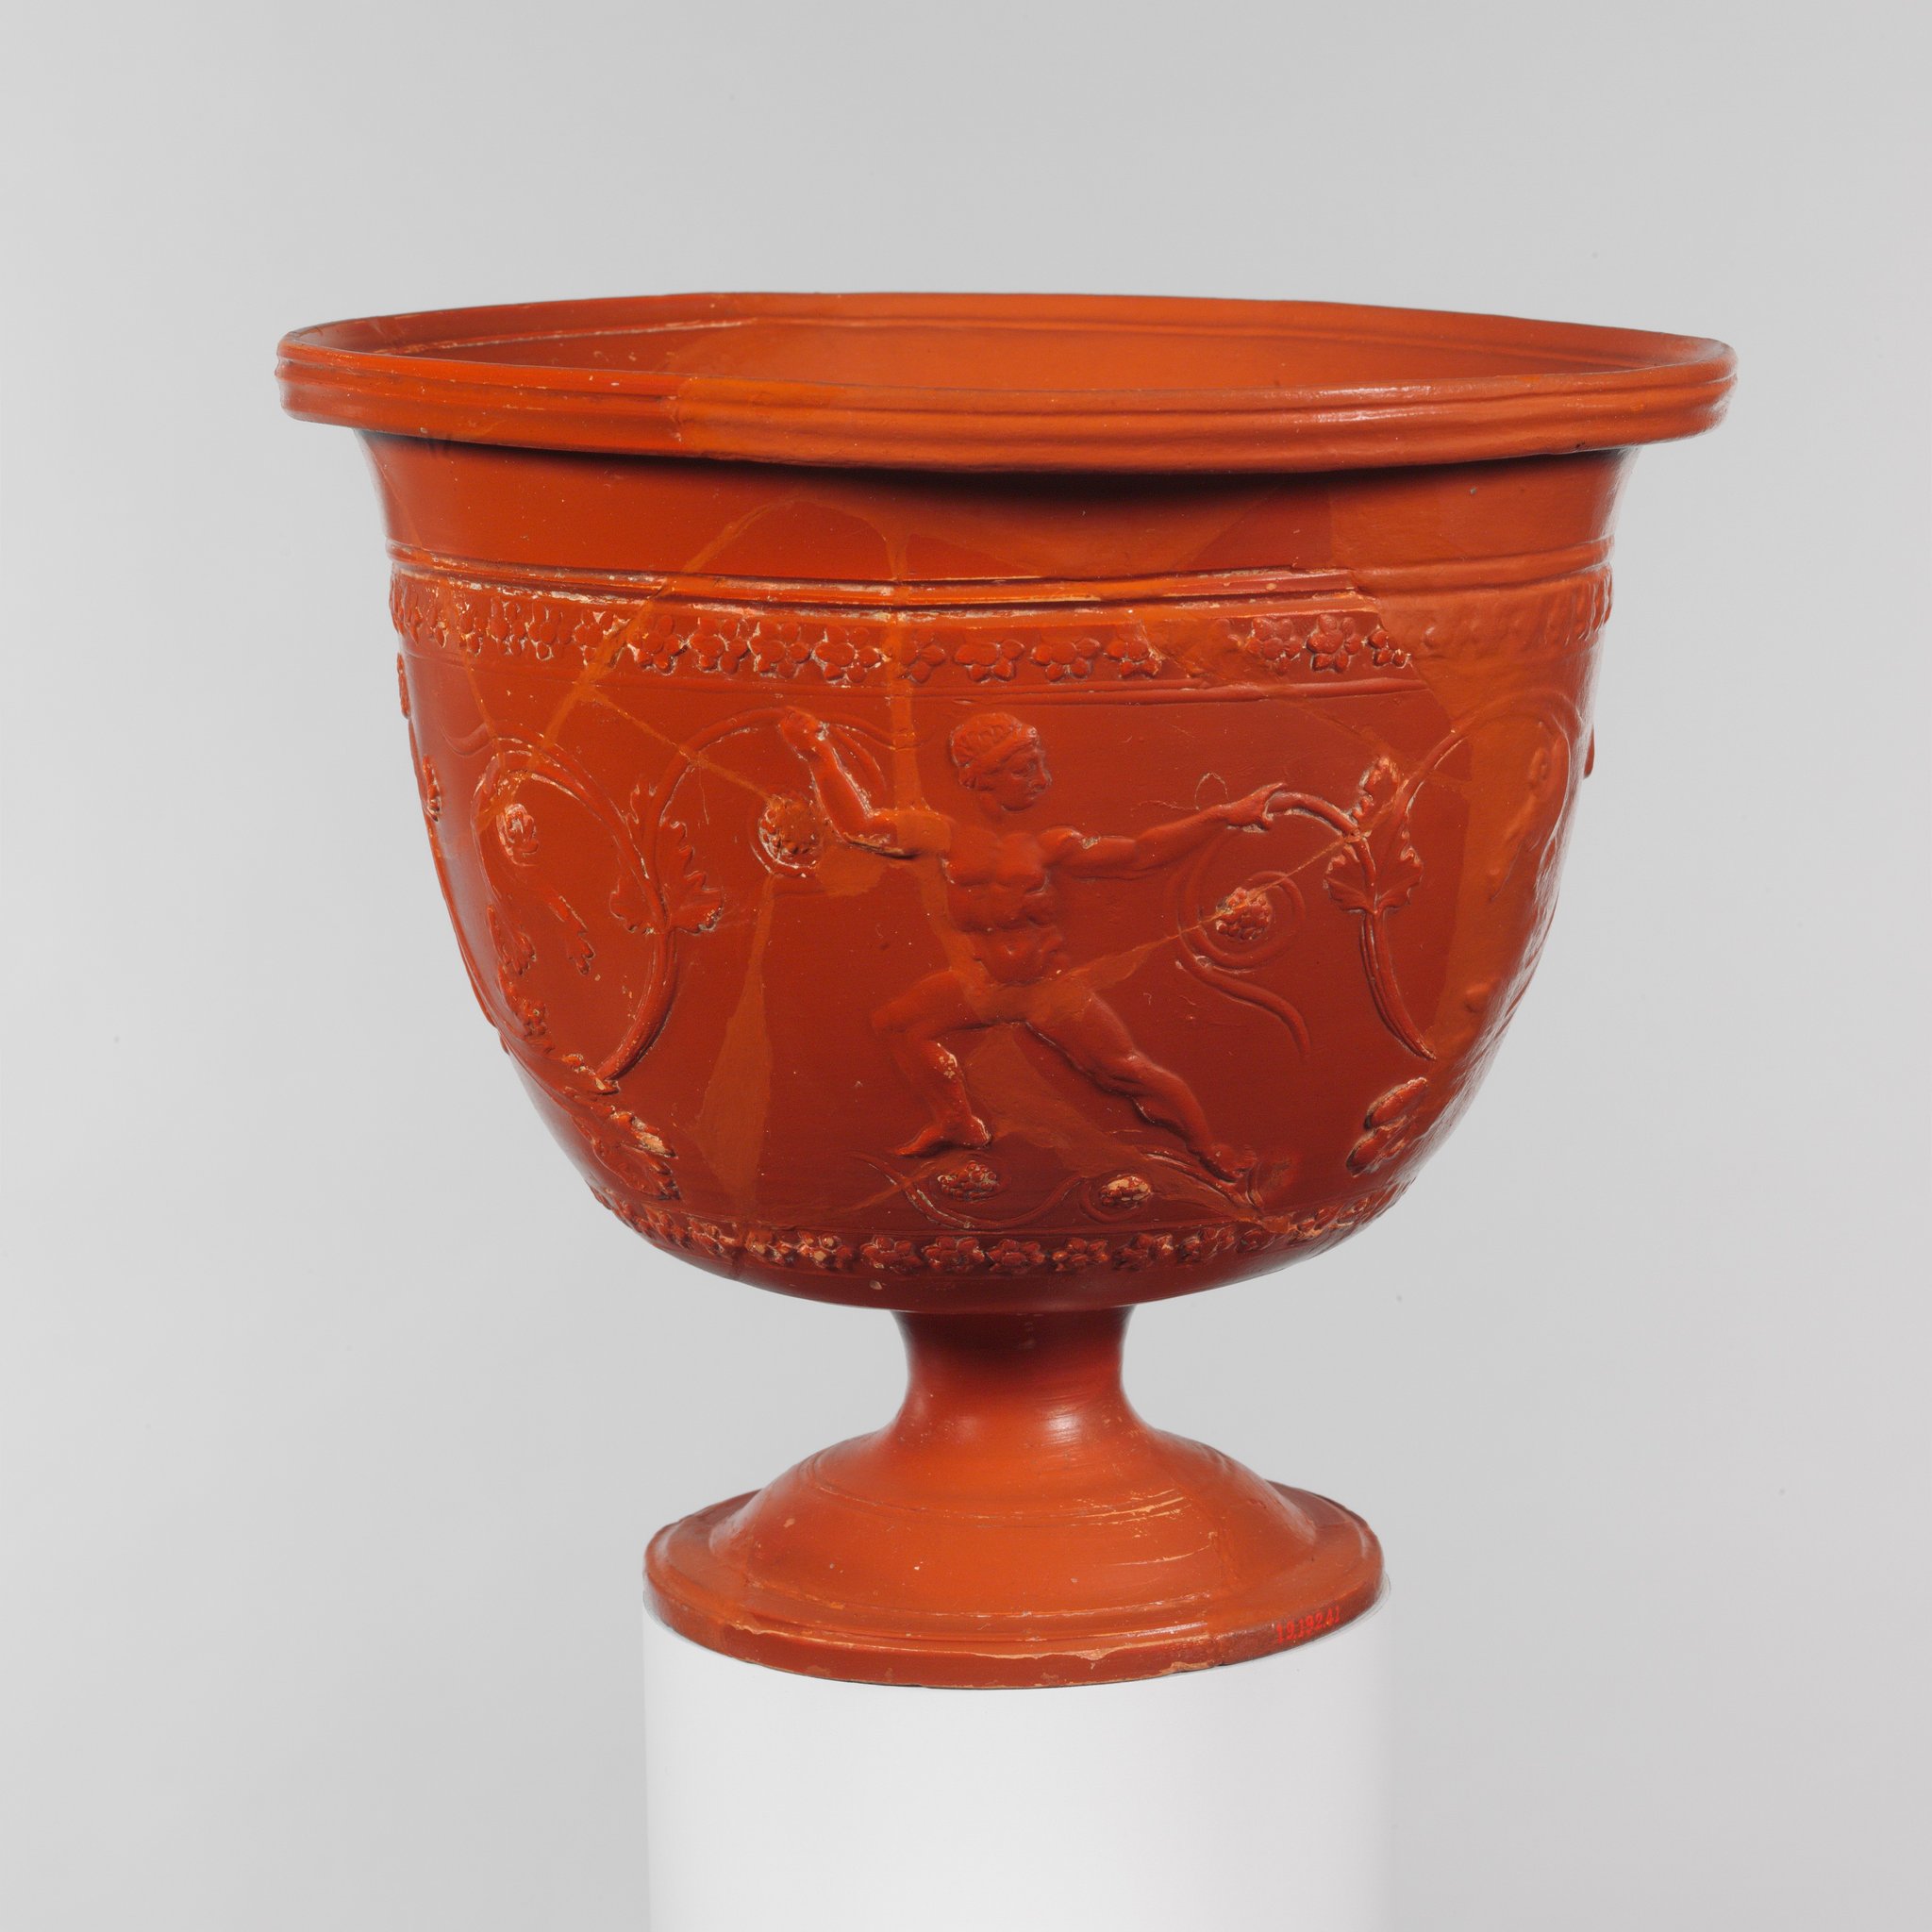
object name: bowl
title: Terracotta bowl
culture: roman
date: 20 BCE-10 CE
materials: terracotta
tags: male nudes